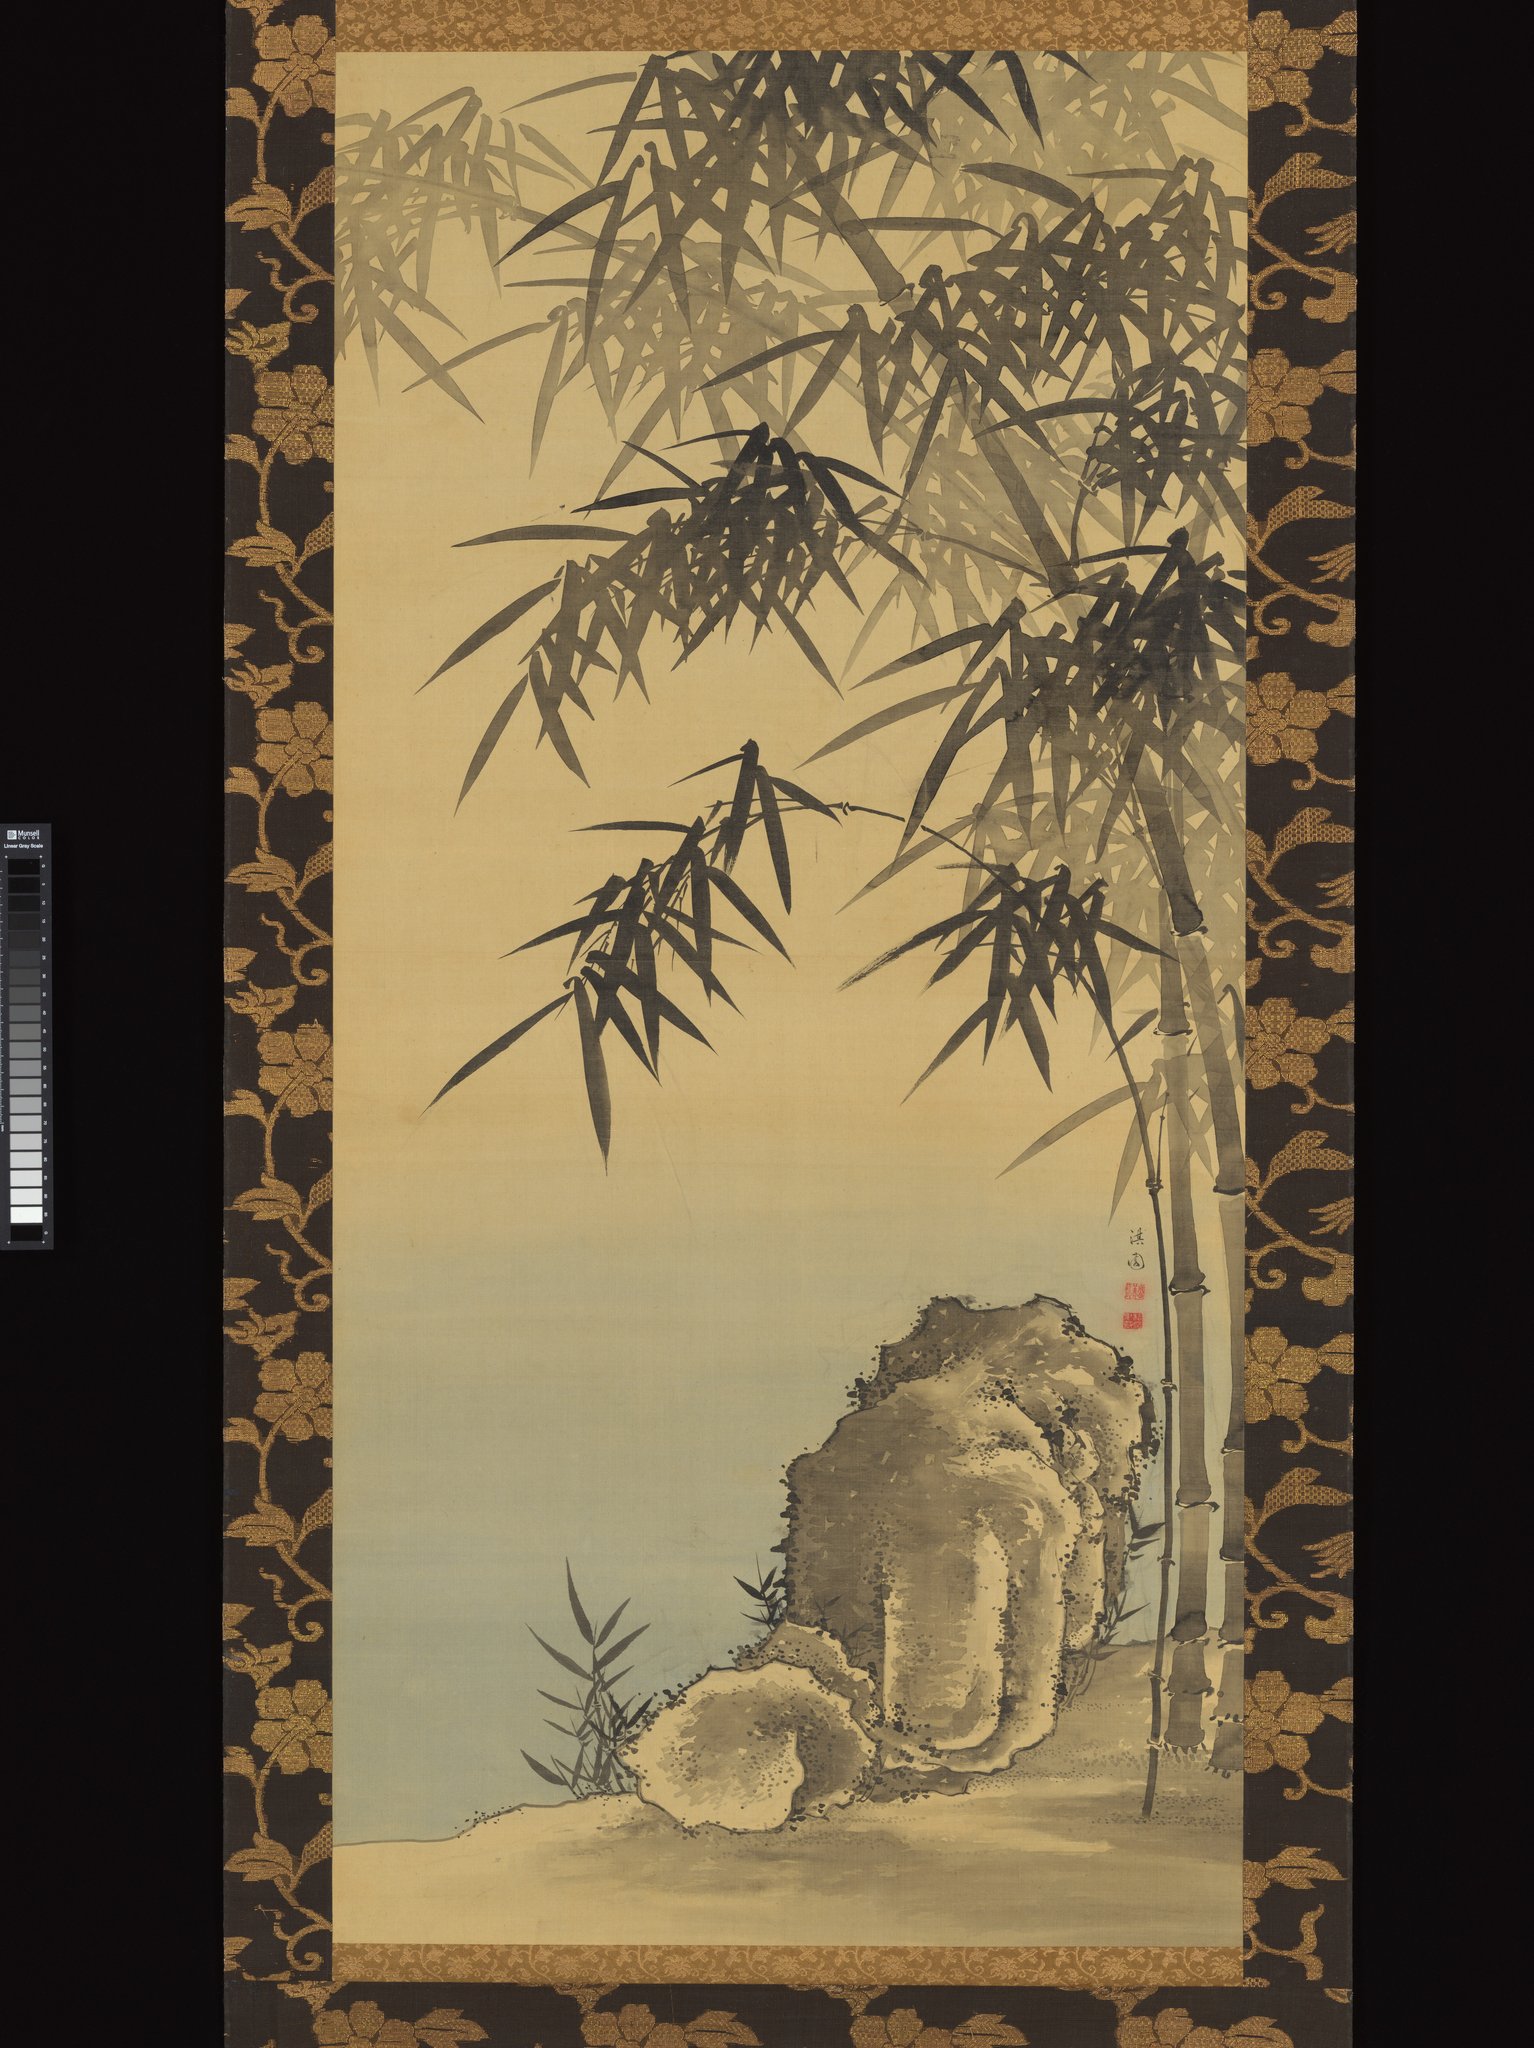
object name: hanging scroll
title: Bamboo and Rocks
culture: japanese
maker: yanagisawa kien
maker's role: artist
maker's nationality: japanese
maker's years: 1703-1758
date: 1750-1758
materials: ink, silk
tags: bamboo